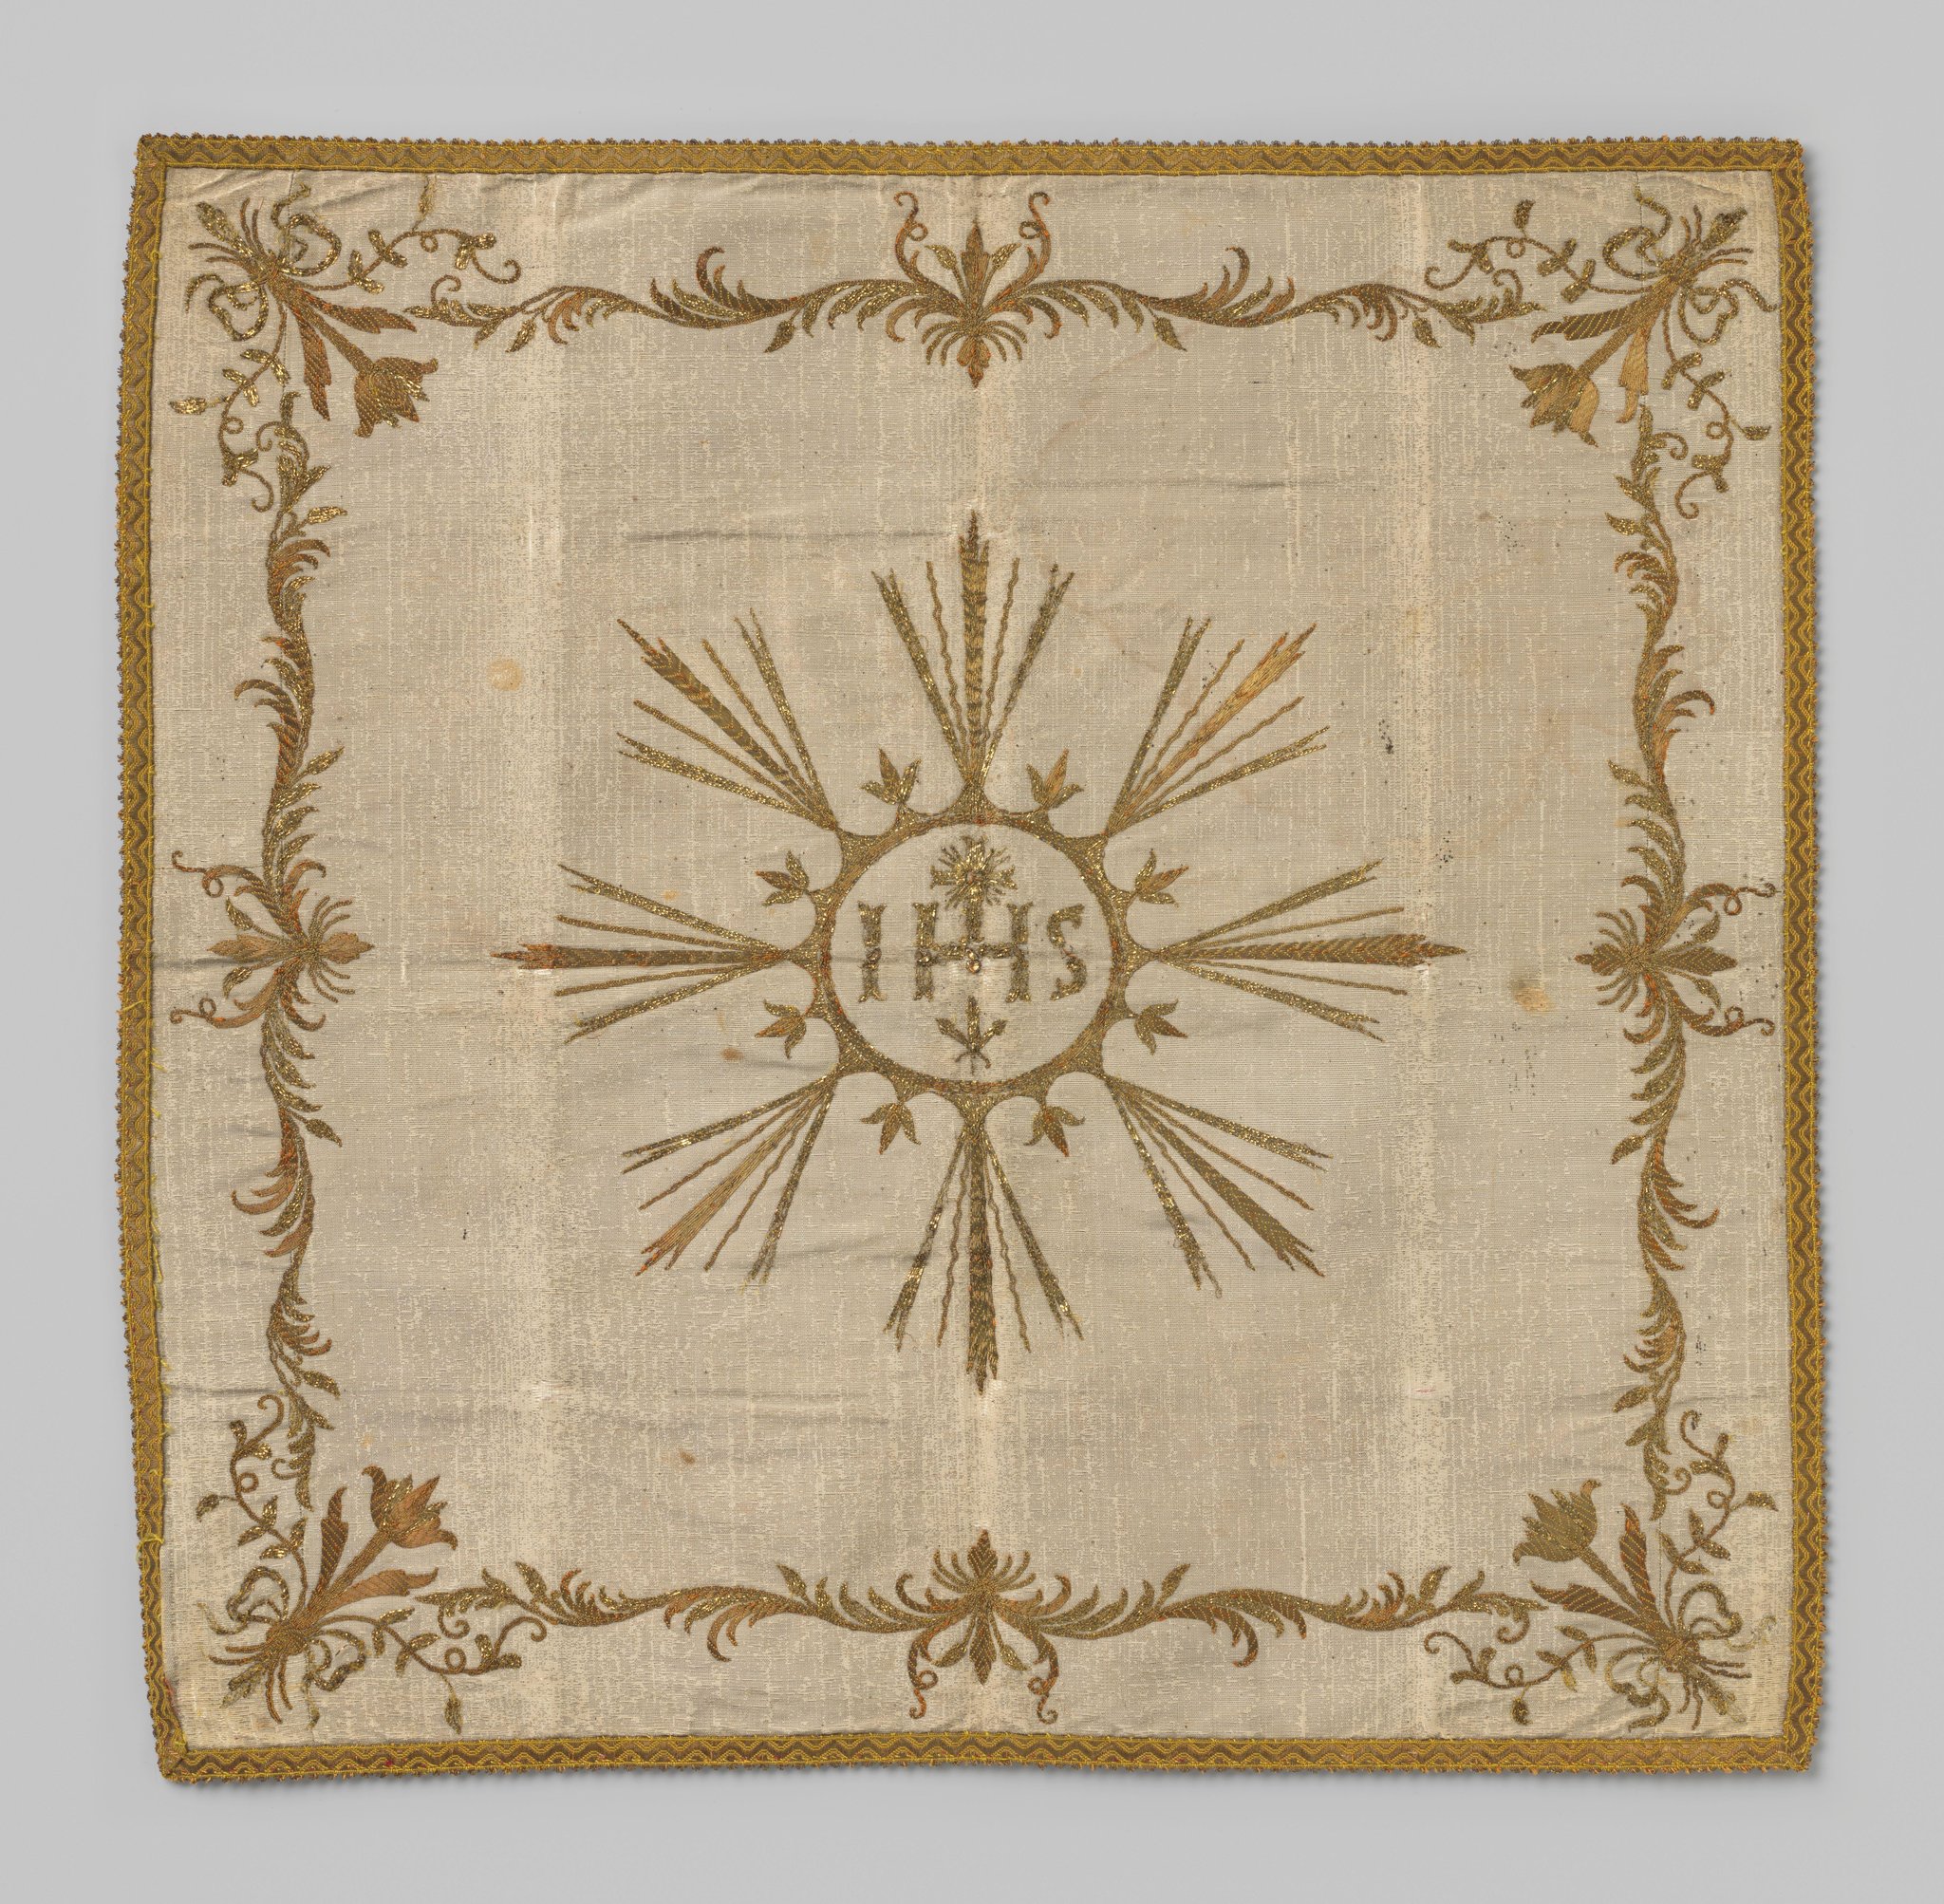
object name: chalice veil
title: Kelkvelum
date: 1750-1800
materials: gold thread, silk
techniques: embroidered, gadrooning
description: Kelkvelum van met zilver doorschoten naturelkleurige zijde waarop met gouddraad geborduurde versiering: in het midden een stralenkrans waarbinnen de letters IHS, langs de randen bladmotieven en schuin in de hoeken een gestileerde bloem. Omboord met een bandje van gele zijde en gouddraad. Voering van zalmkleurige zijde.